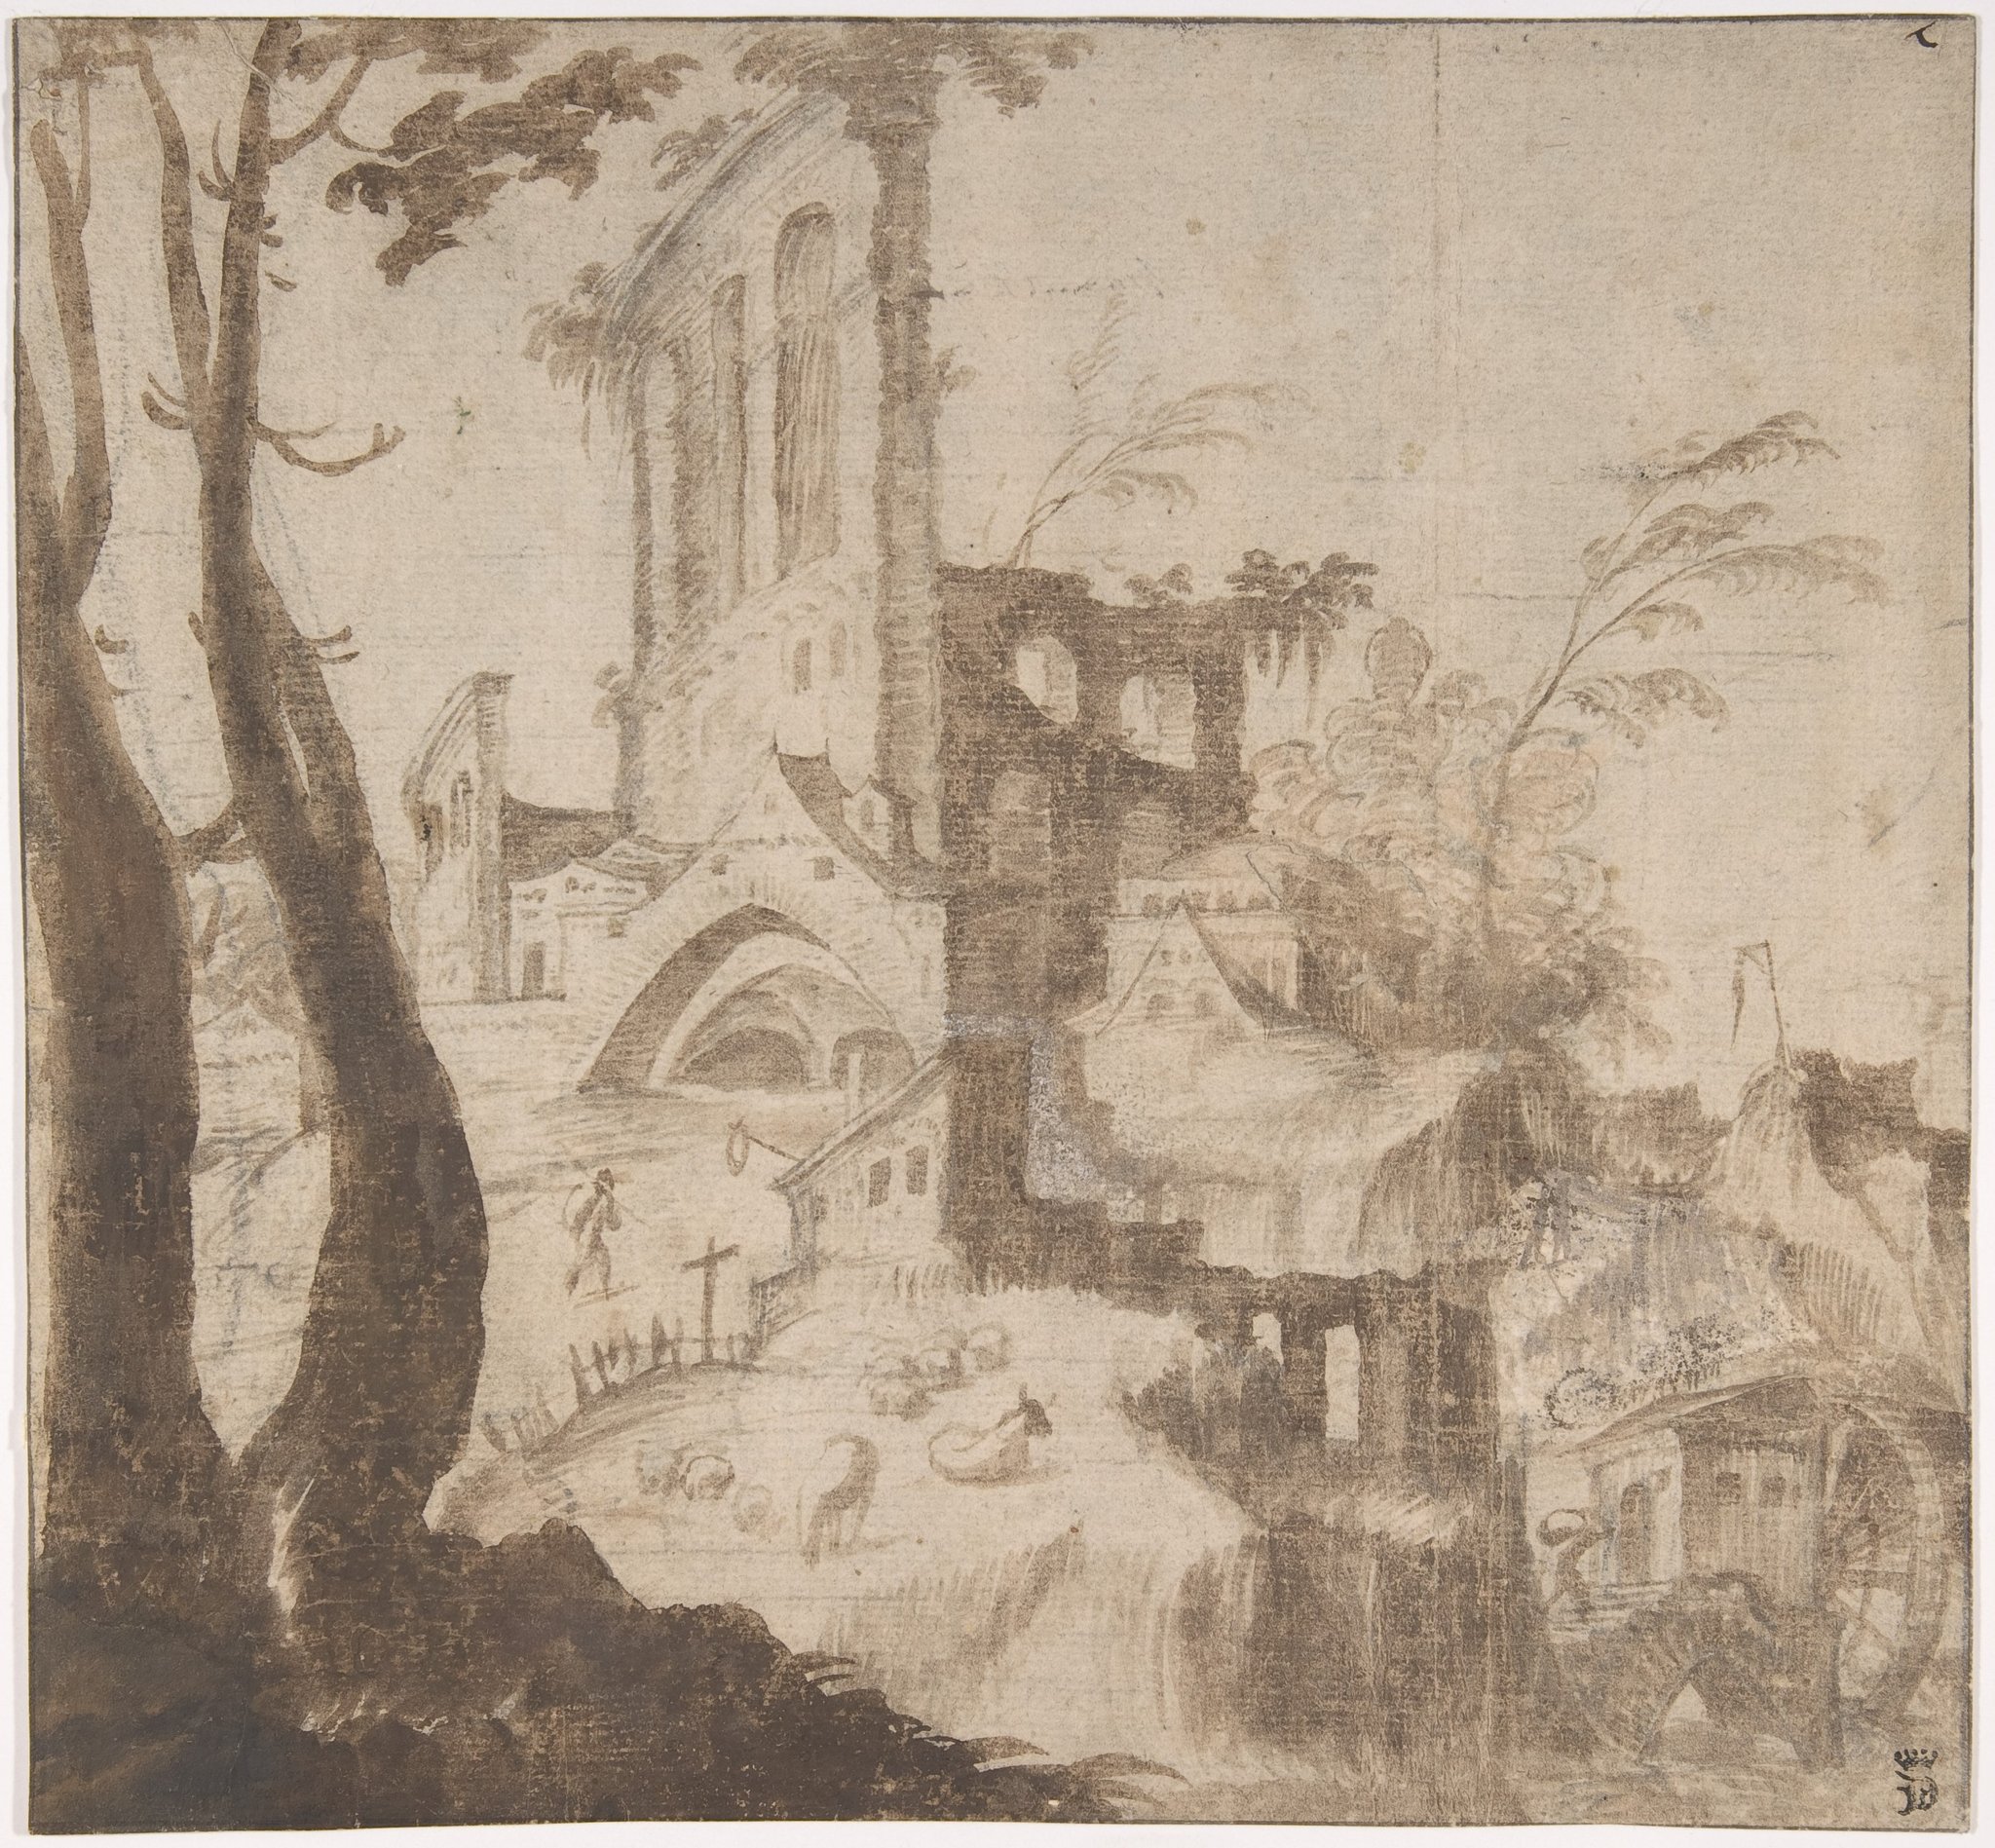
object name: drawing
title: Imaginary Hilly Landscape with Ruins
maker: anonymous, netherlandish, 16th century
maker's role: artist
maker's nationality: netherlandish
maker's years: 1500-1600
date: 1501-1600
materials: chalk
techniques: brush, heightening, wash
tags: human figures,animals,ruins,trees